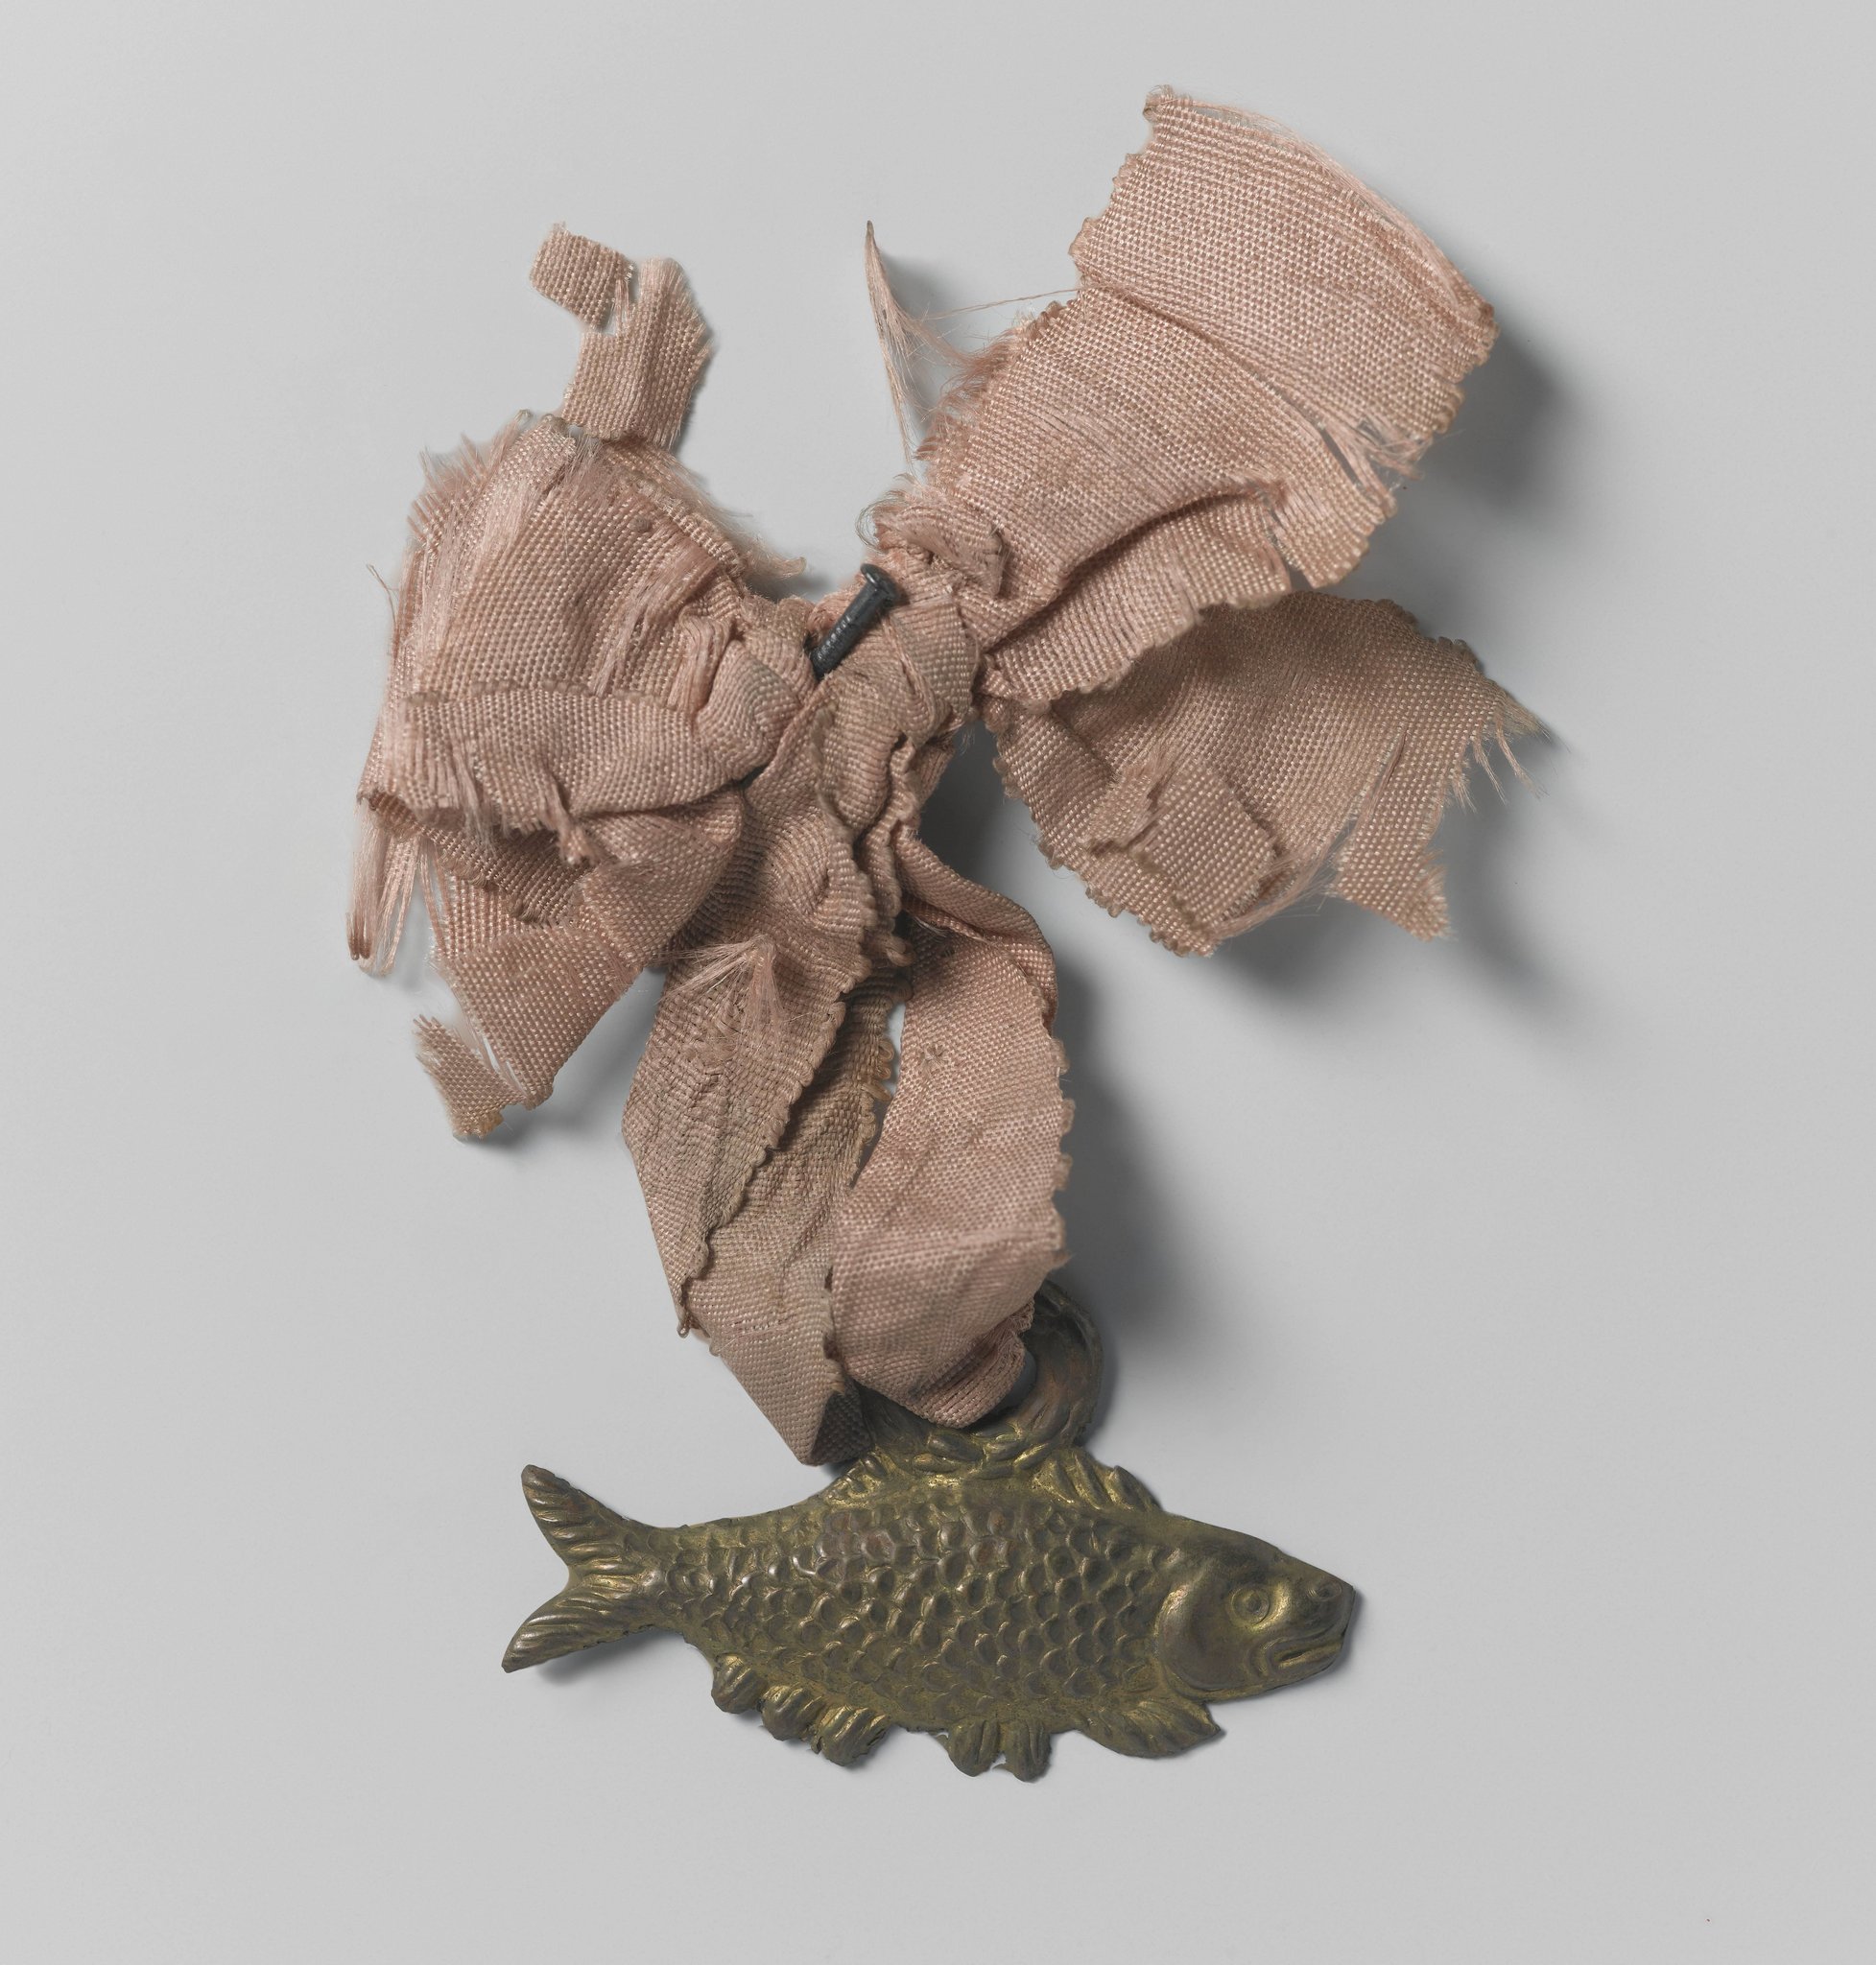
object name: insignia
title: Visdragers van Amsterdam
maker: Anonymous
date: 1800-1875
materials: brass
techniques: casting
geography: amsterdam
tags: amsterdam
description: Messing draagteken in vorm van holle vis met kop naar rechts, aan draagoog en zalmkleurig lint. Voorzijde: vis. Keerzijde: blanco.